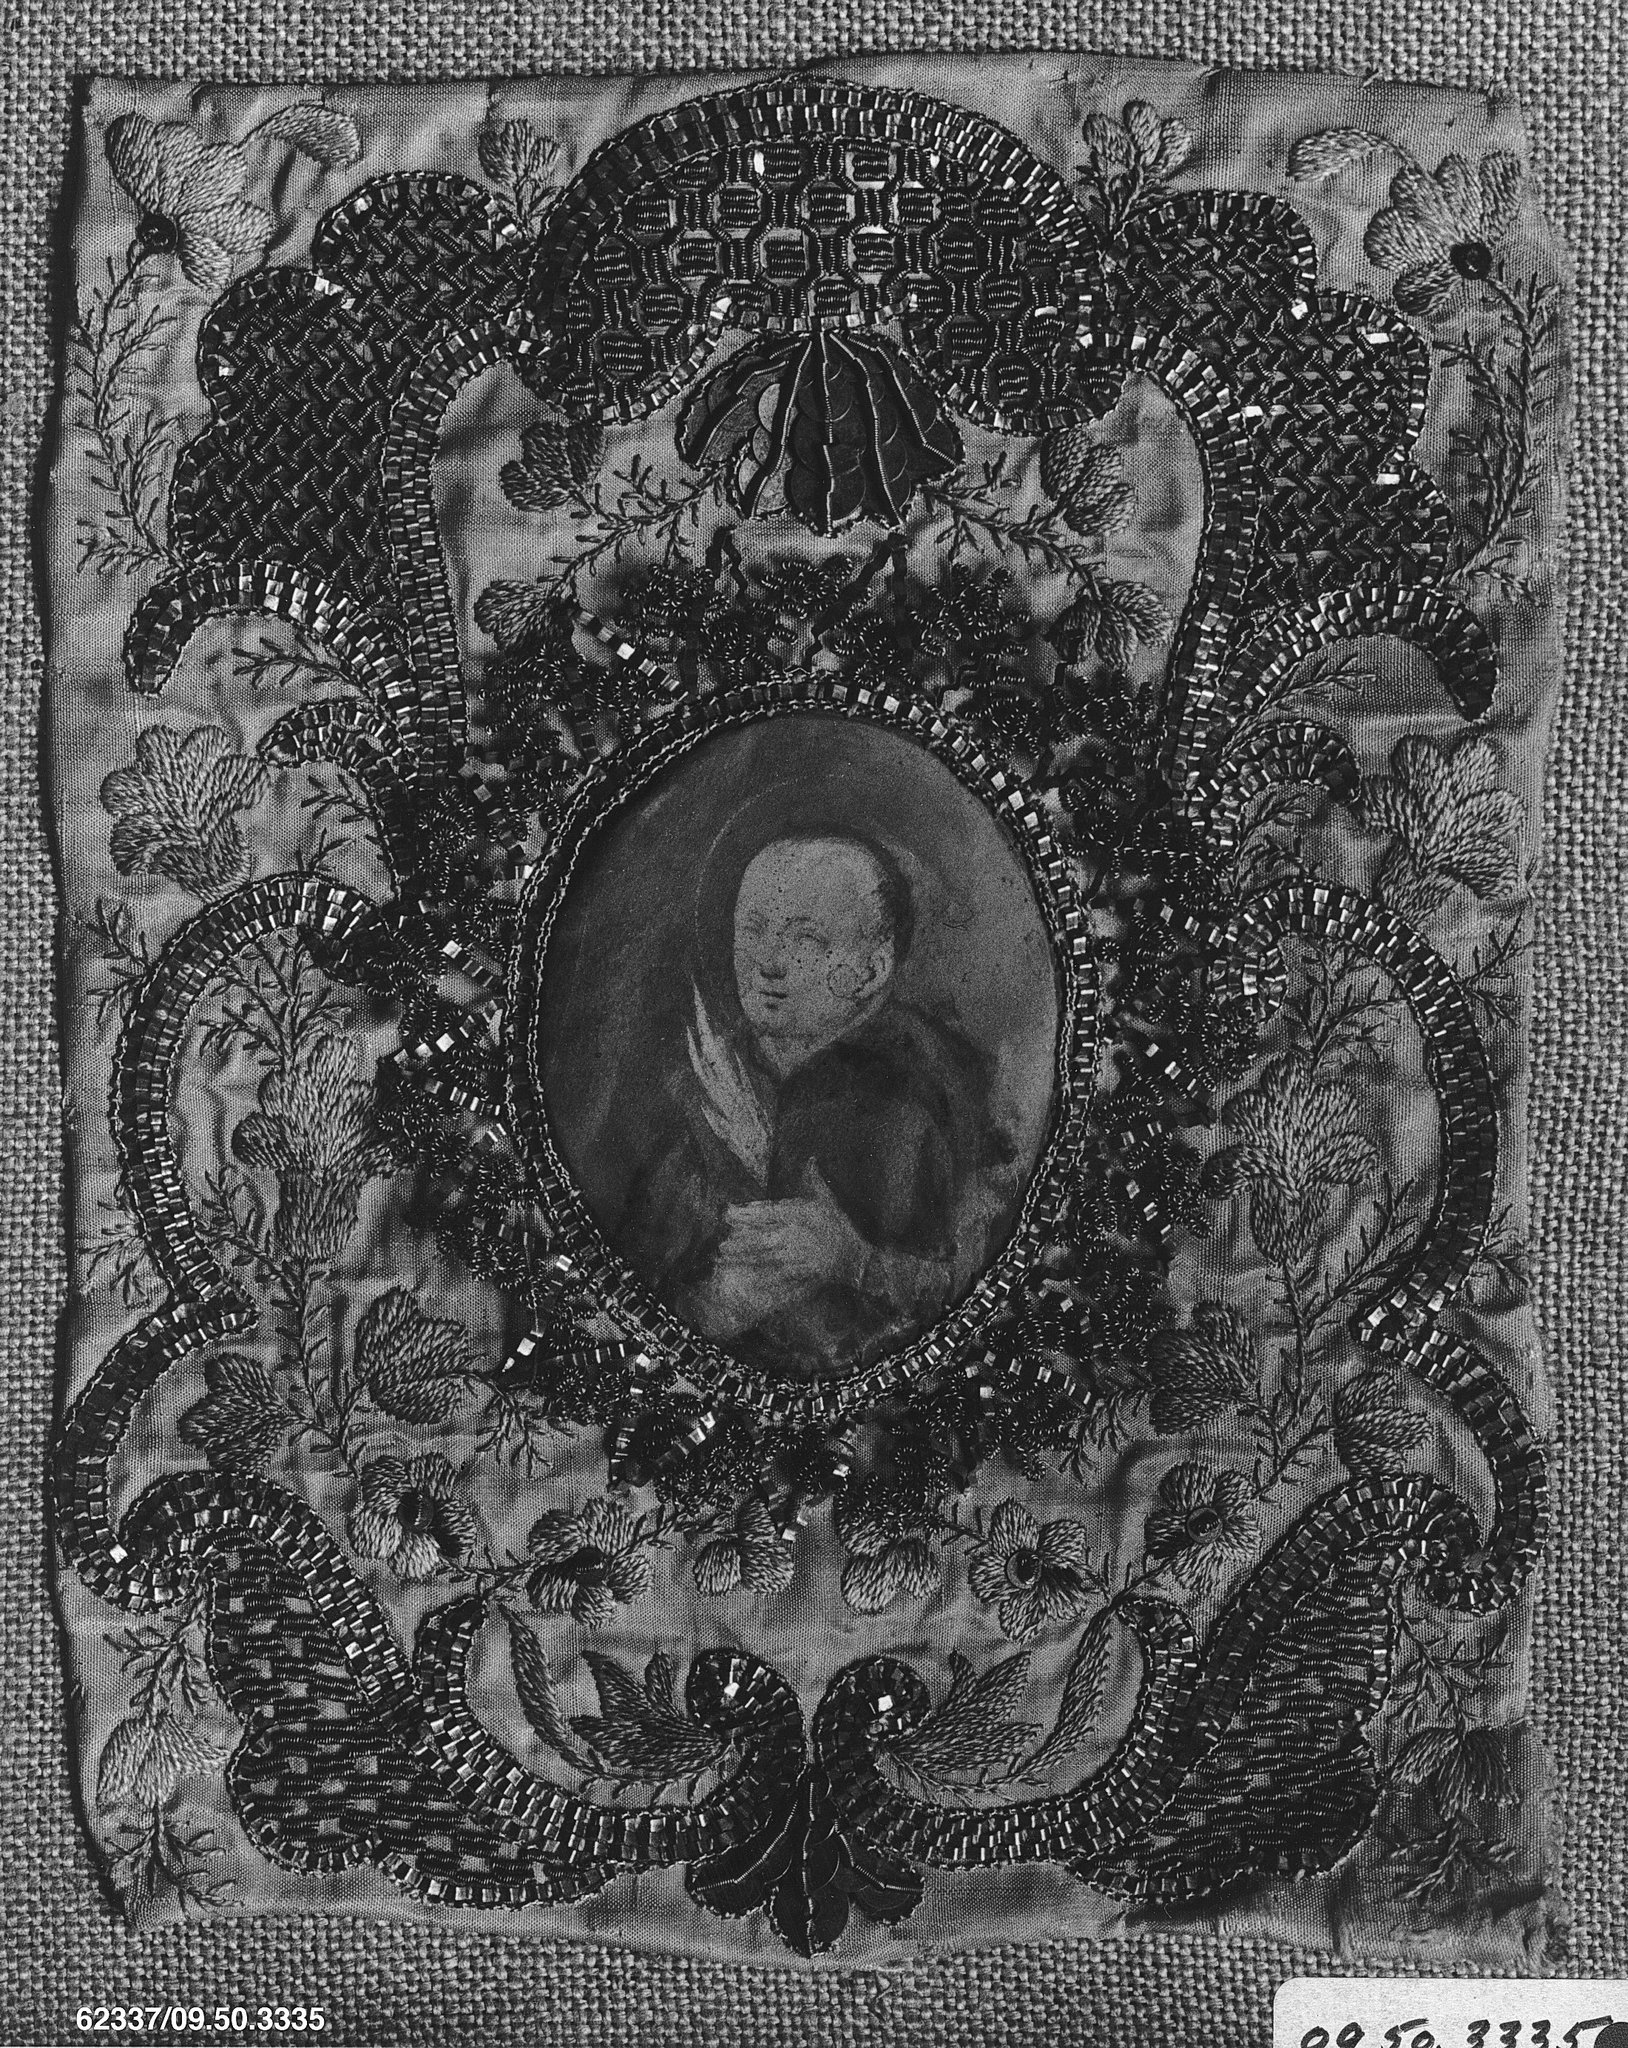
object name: book cover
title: Cover for a prayer book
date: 1701-1800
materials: metal thread, silk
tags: men,portraits,flowers